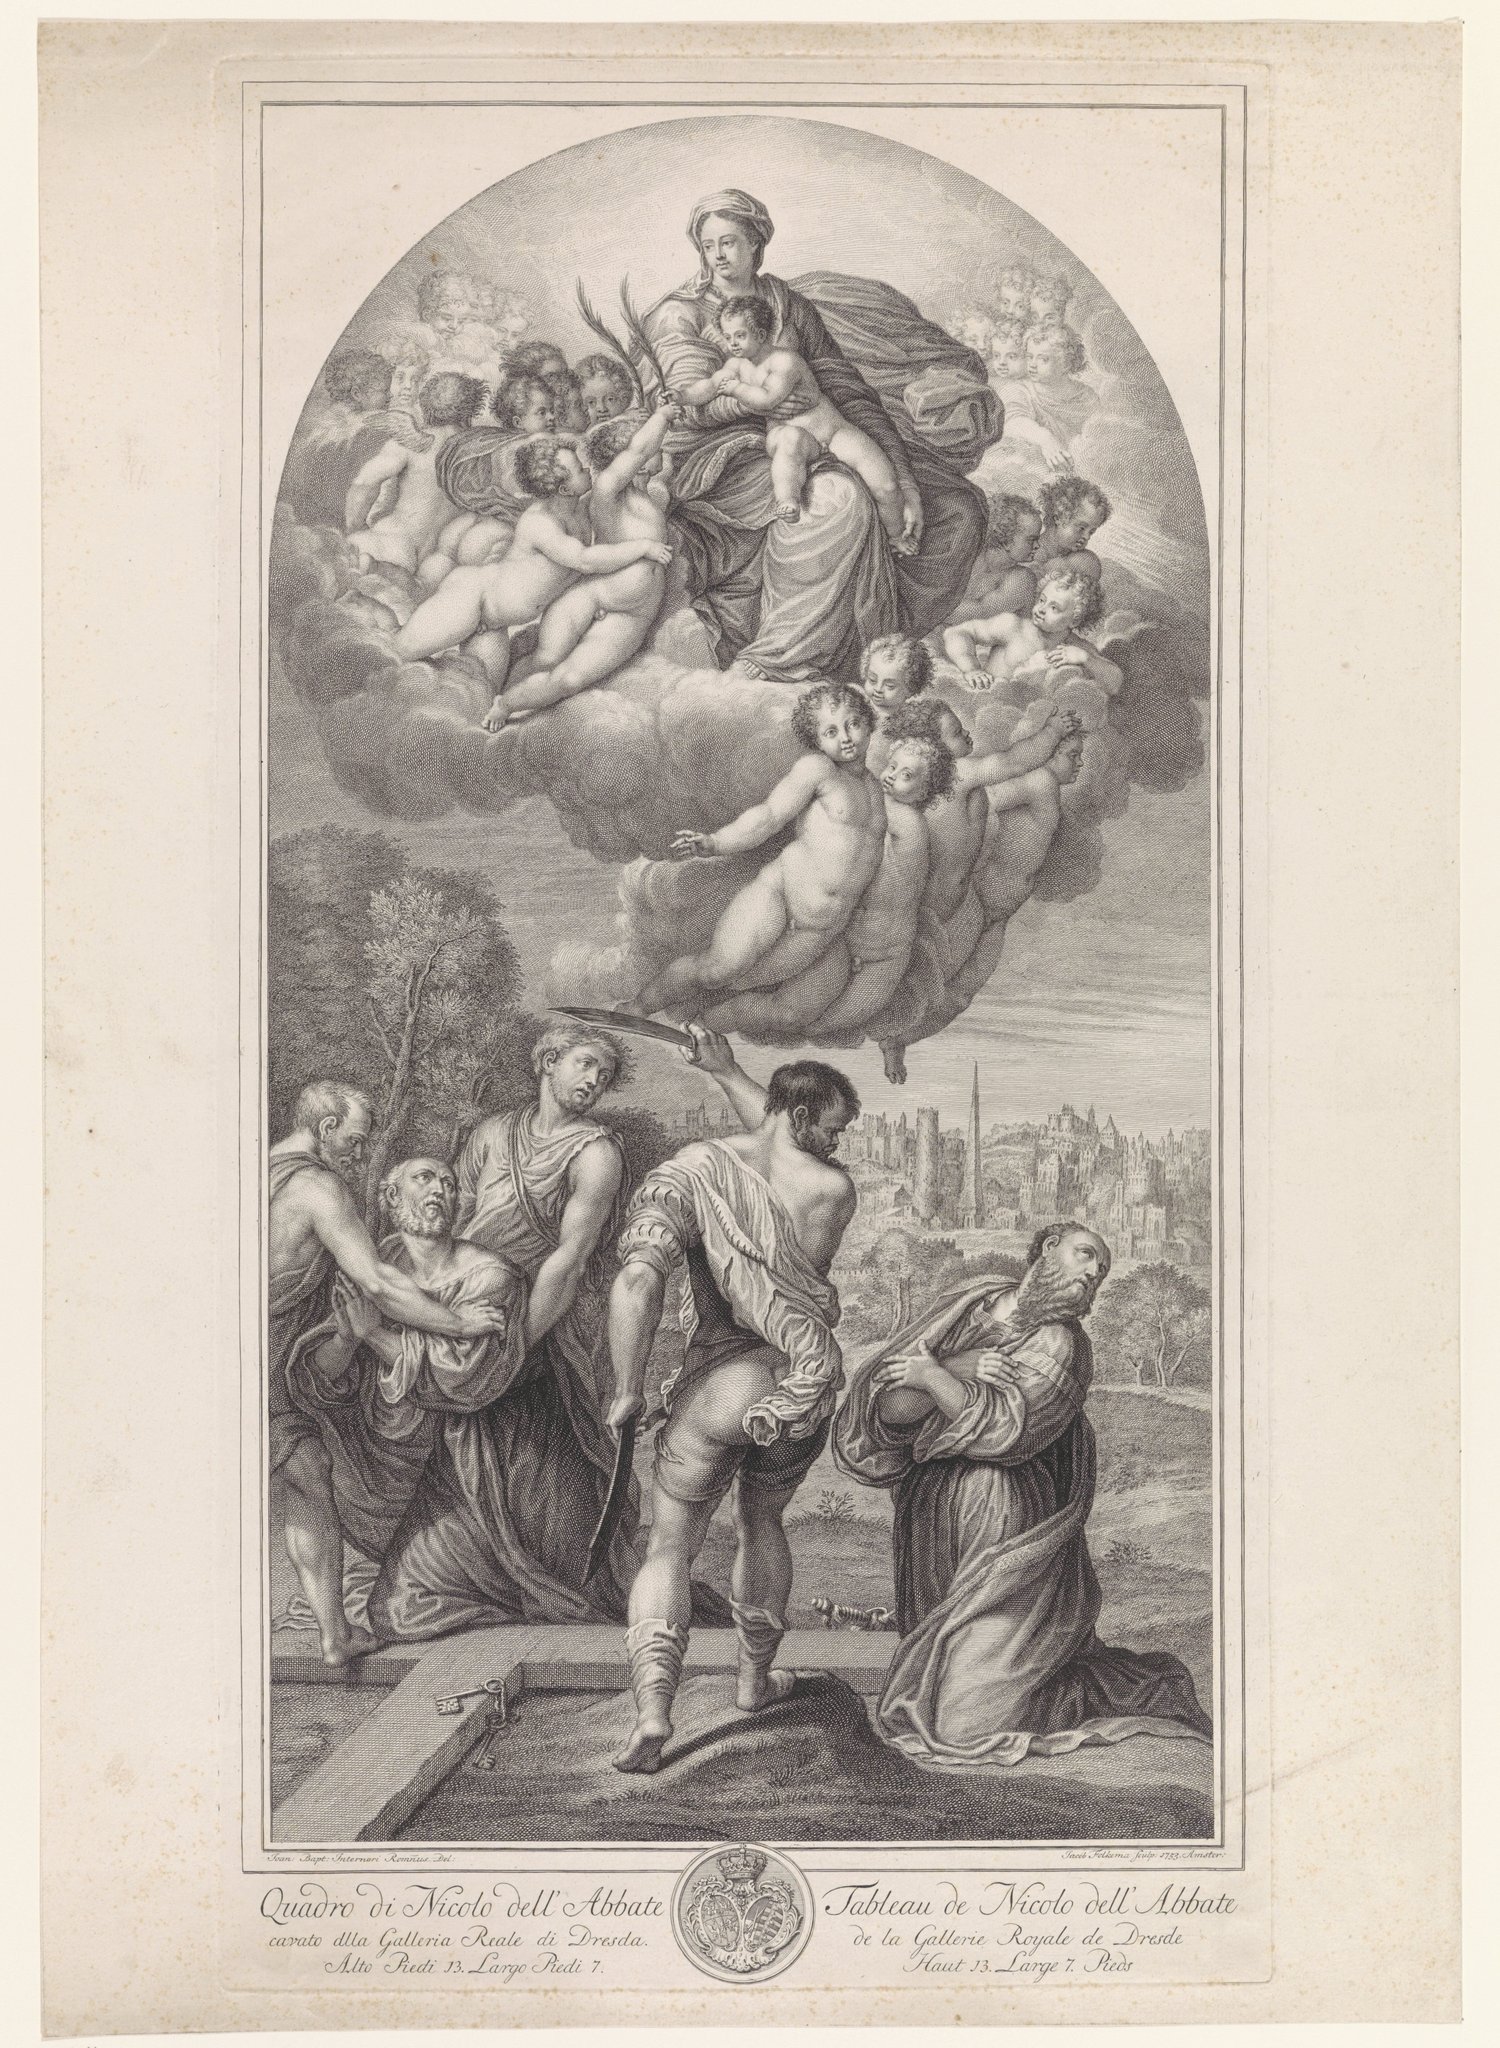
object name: print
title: Martelaarschap van H. Paulus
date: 1753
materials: paper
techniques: engraving, etching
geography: amsterdam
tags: mary sitting or enthroned, the christ-child sitting on her knee (christ-child to mary's left) (+ angel(s)), peter and paul meet (and embrace) just before their execution, martyrdom and death of paul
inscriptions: collector's mark: Lugt 240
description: De heilige Paulus zit geknield voor de beul die hem met een zwaard zal onthoofden. Links de heilige Petrus, met voor hem op de grond zijn attribuut, de sleutels van de hemel en het kruis waarop hij zal sterven. Bovenaan Maria met het Christuskind tussen de wolken omringd door putti.